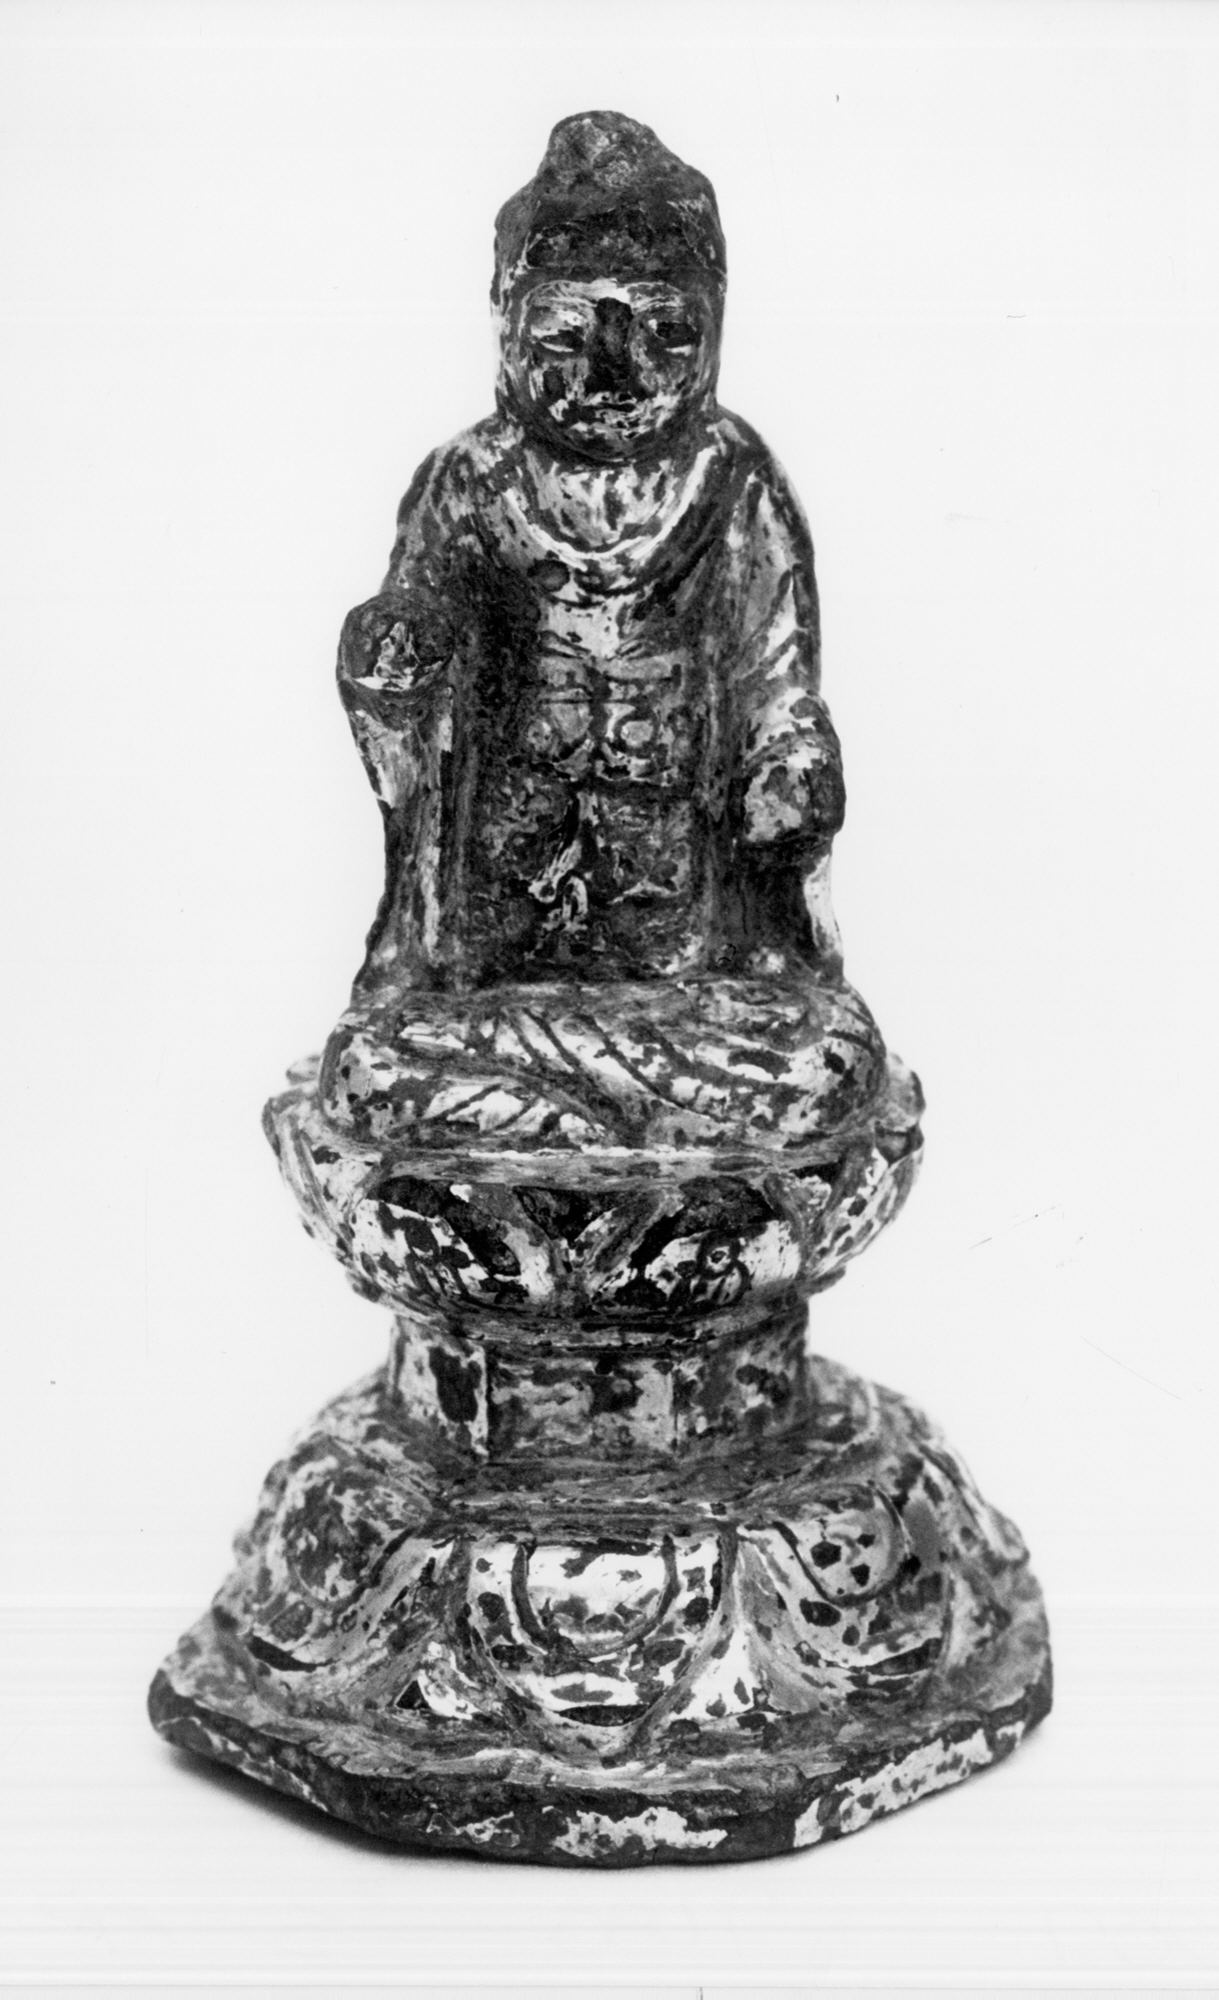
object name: statuette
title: Statuette of Buddha Sitting on Engraved Throne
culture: korean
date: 901-1000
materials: gilt bronze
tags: buddhism,buddha